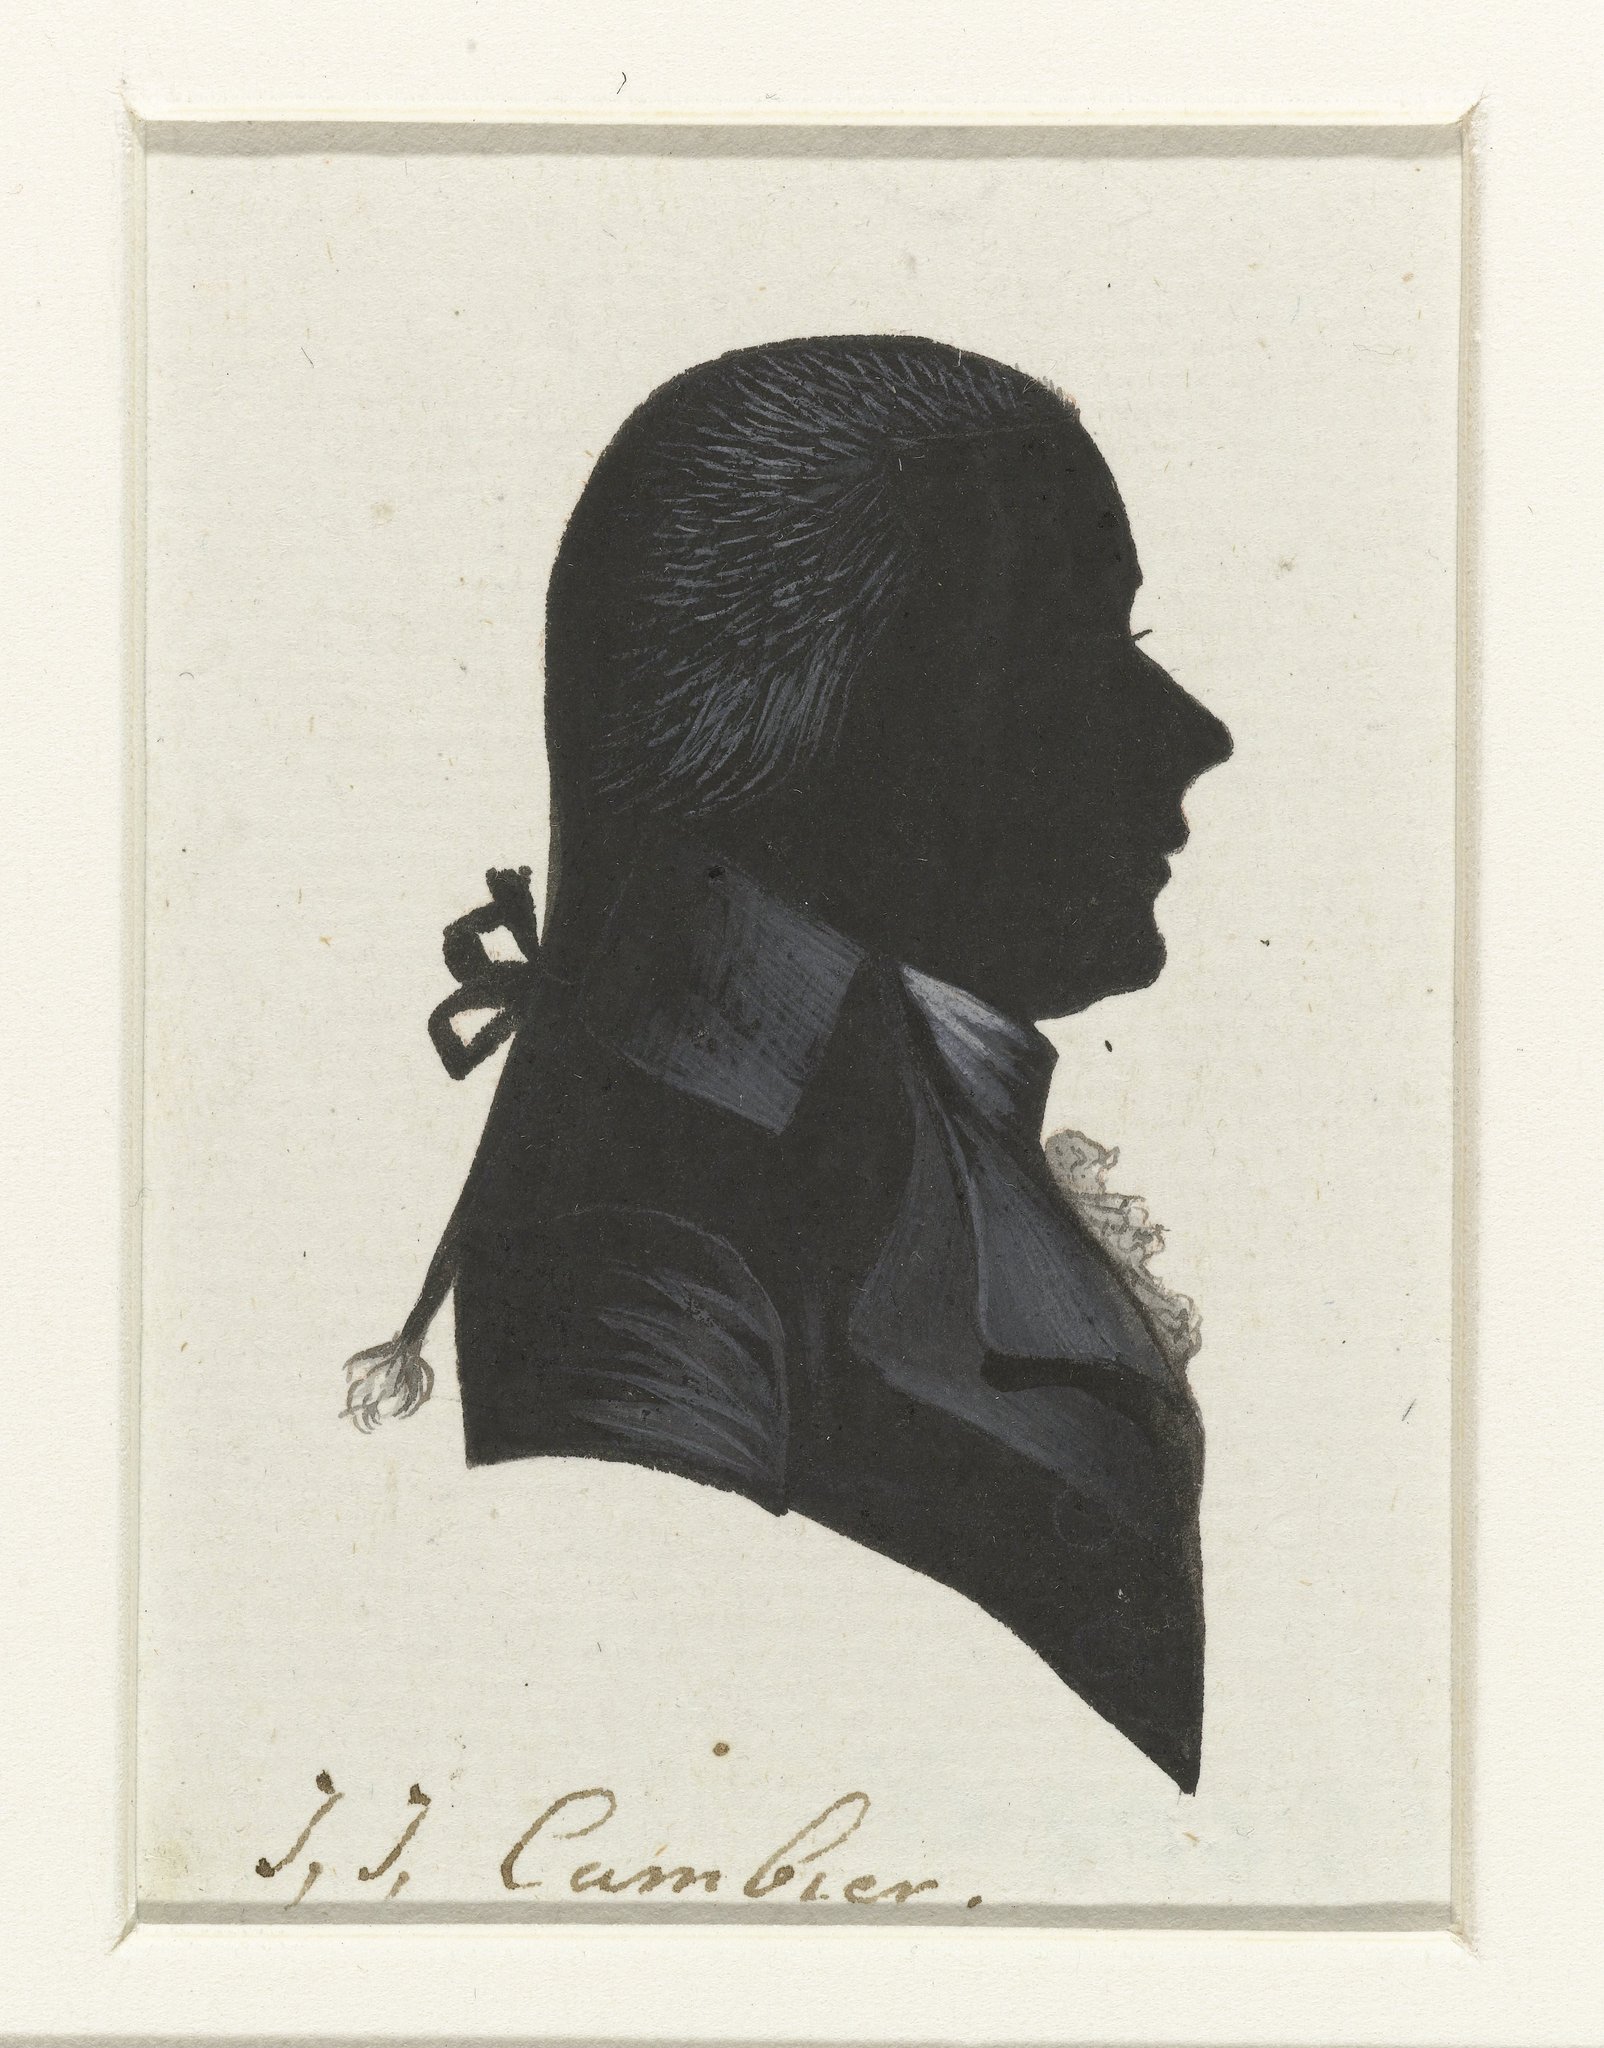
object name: silhouette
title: J.J. Cambier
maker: hausdorff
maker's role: draughtsman, print maker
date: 1796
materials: ink, paper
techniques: drawing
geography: netherlands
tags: jacob jan cambier, historical persons (+ profile portrait), the hague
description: Silhouettes of members of the National Assembly. India ink on paper, 1796. Early in 1795 Stadholder William V fled to England. In the Republic a new regime was installed. A year later, the country held its first general election. Every Dutch man over the age of twenty and not on poor relief was entitled to vote for a candidate to the National Assembly, the parliament of the Batavian Republic, as the country was known between 1795 and 1806. The 126 representatives who sat in the assembly were drawn from the educated, progressive elite of Dutch society.